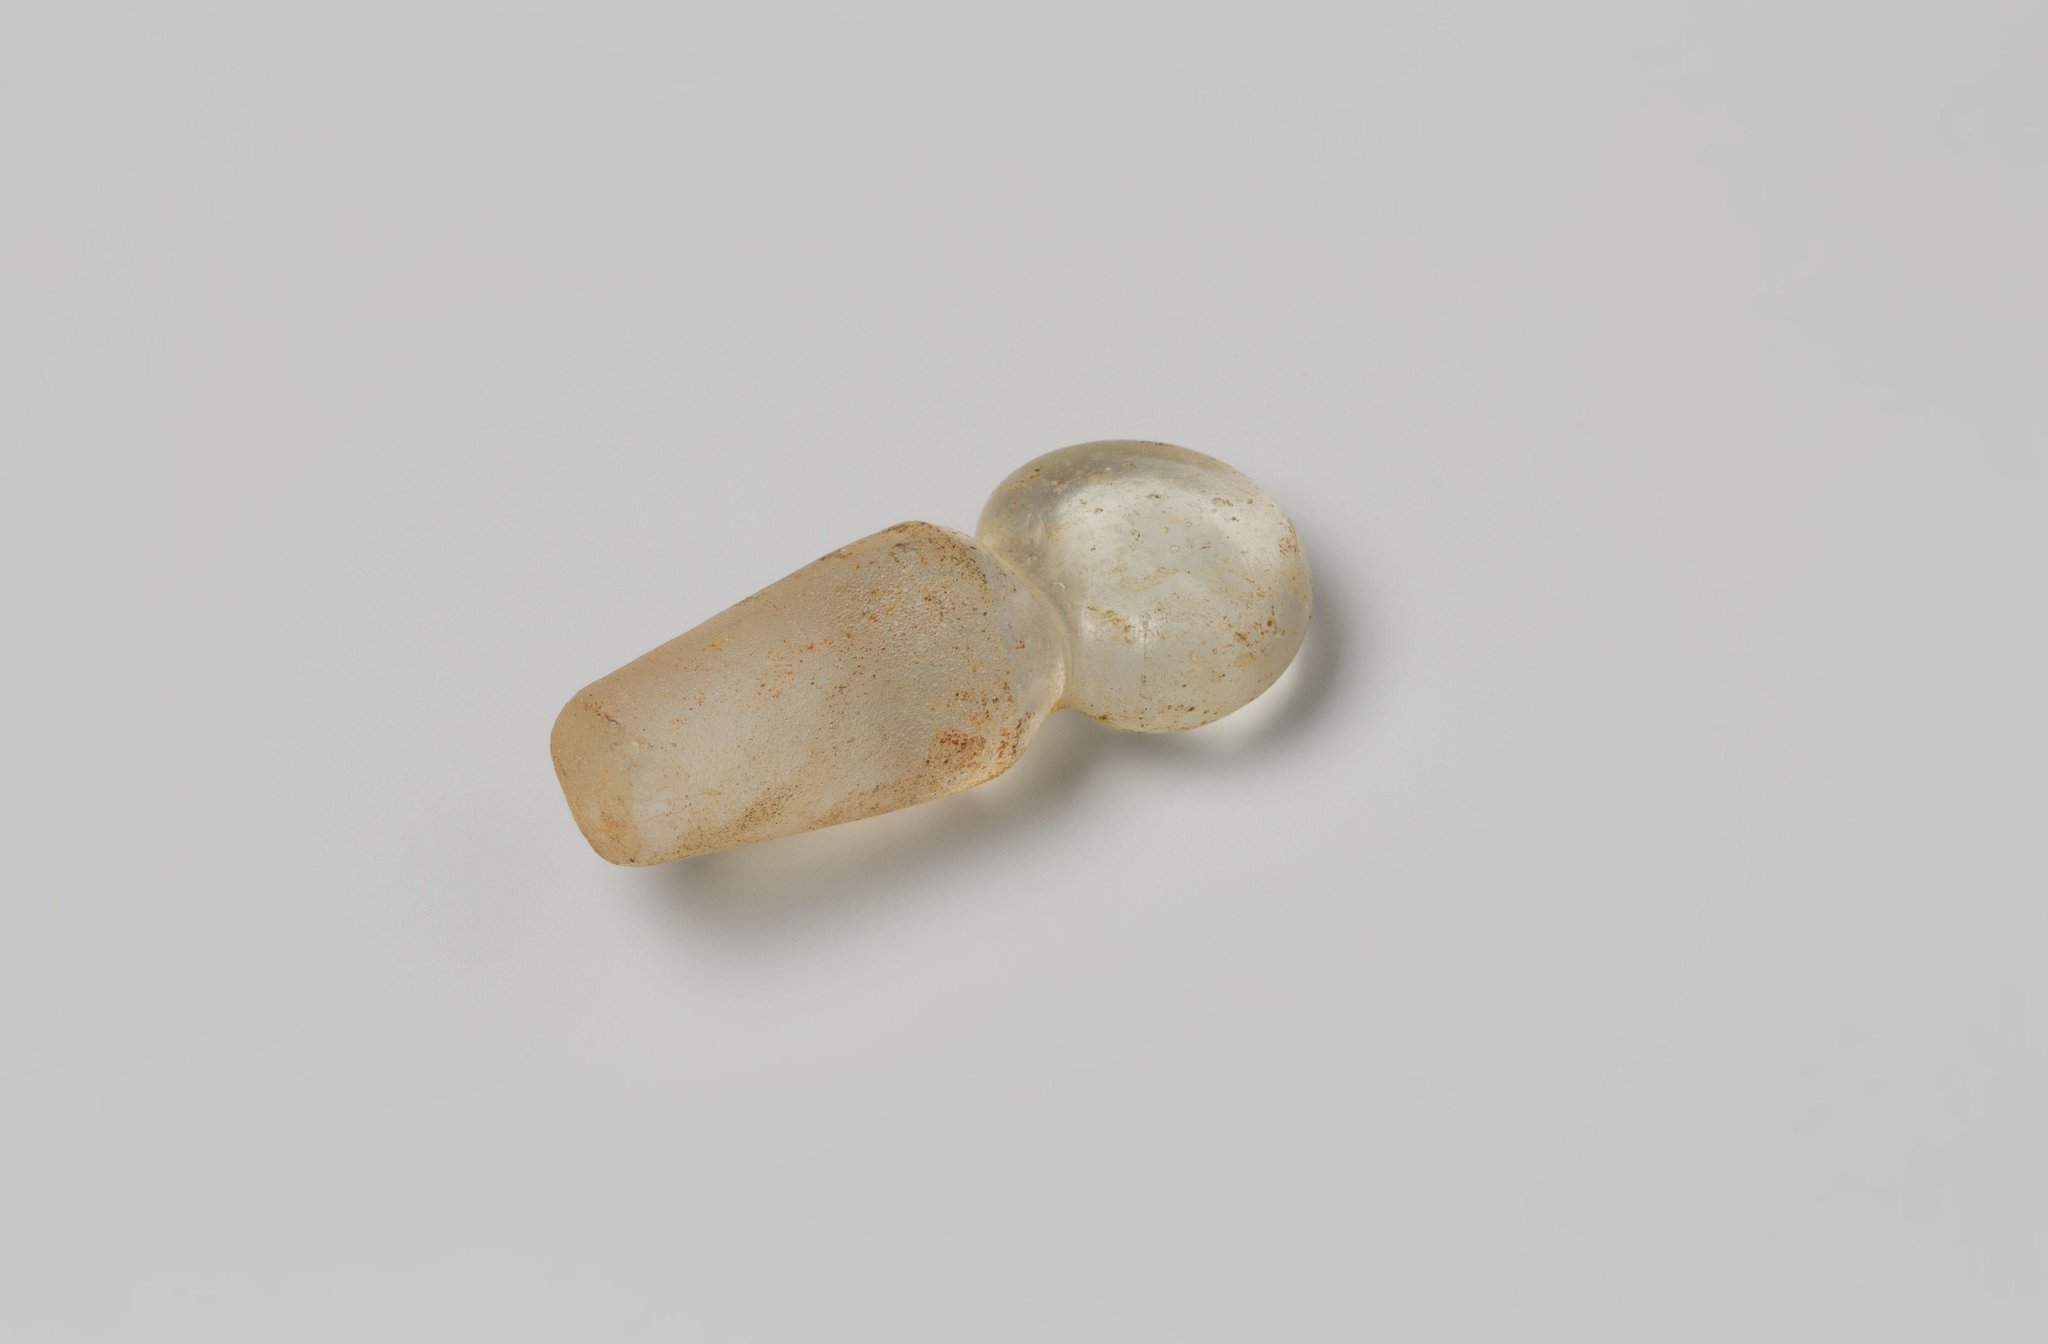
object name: bung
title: Stop van vaatwerk uit het wrak van de Oost-Indiëvaarder Hollandia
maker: Anonymous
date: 1700-1743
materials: glass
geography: netherlands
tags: verenigde oostindische compagnie, hollandia (schip), annet